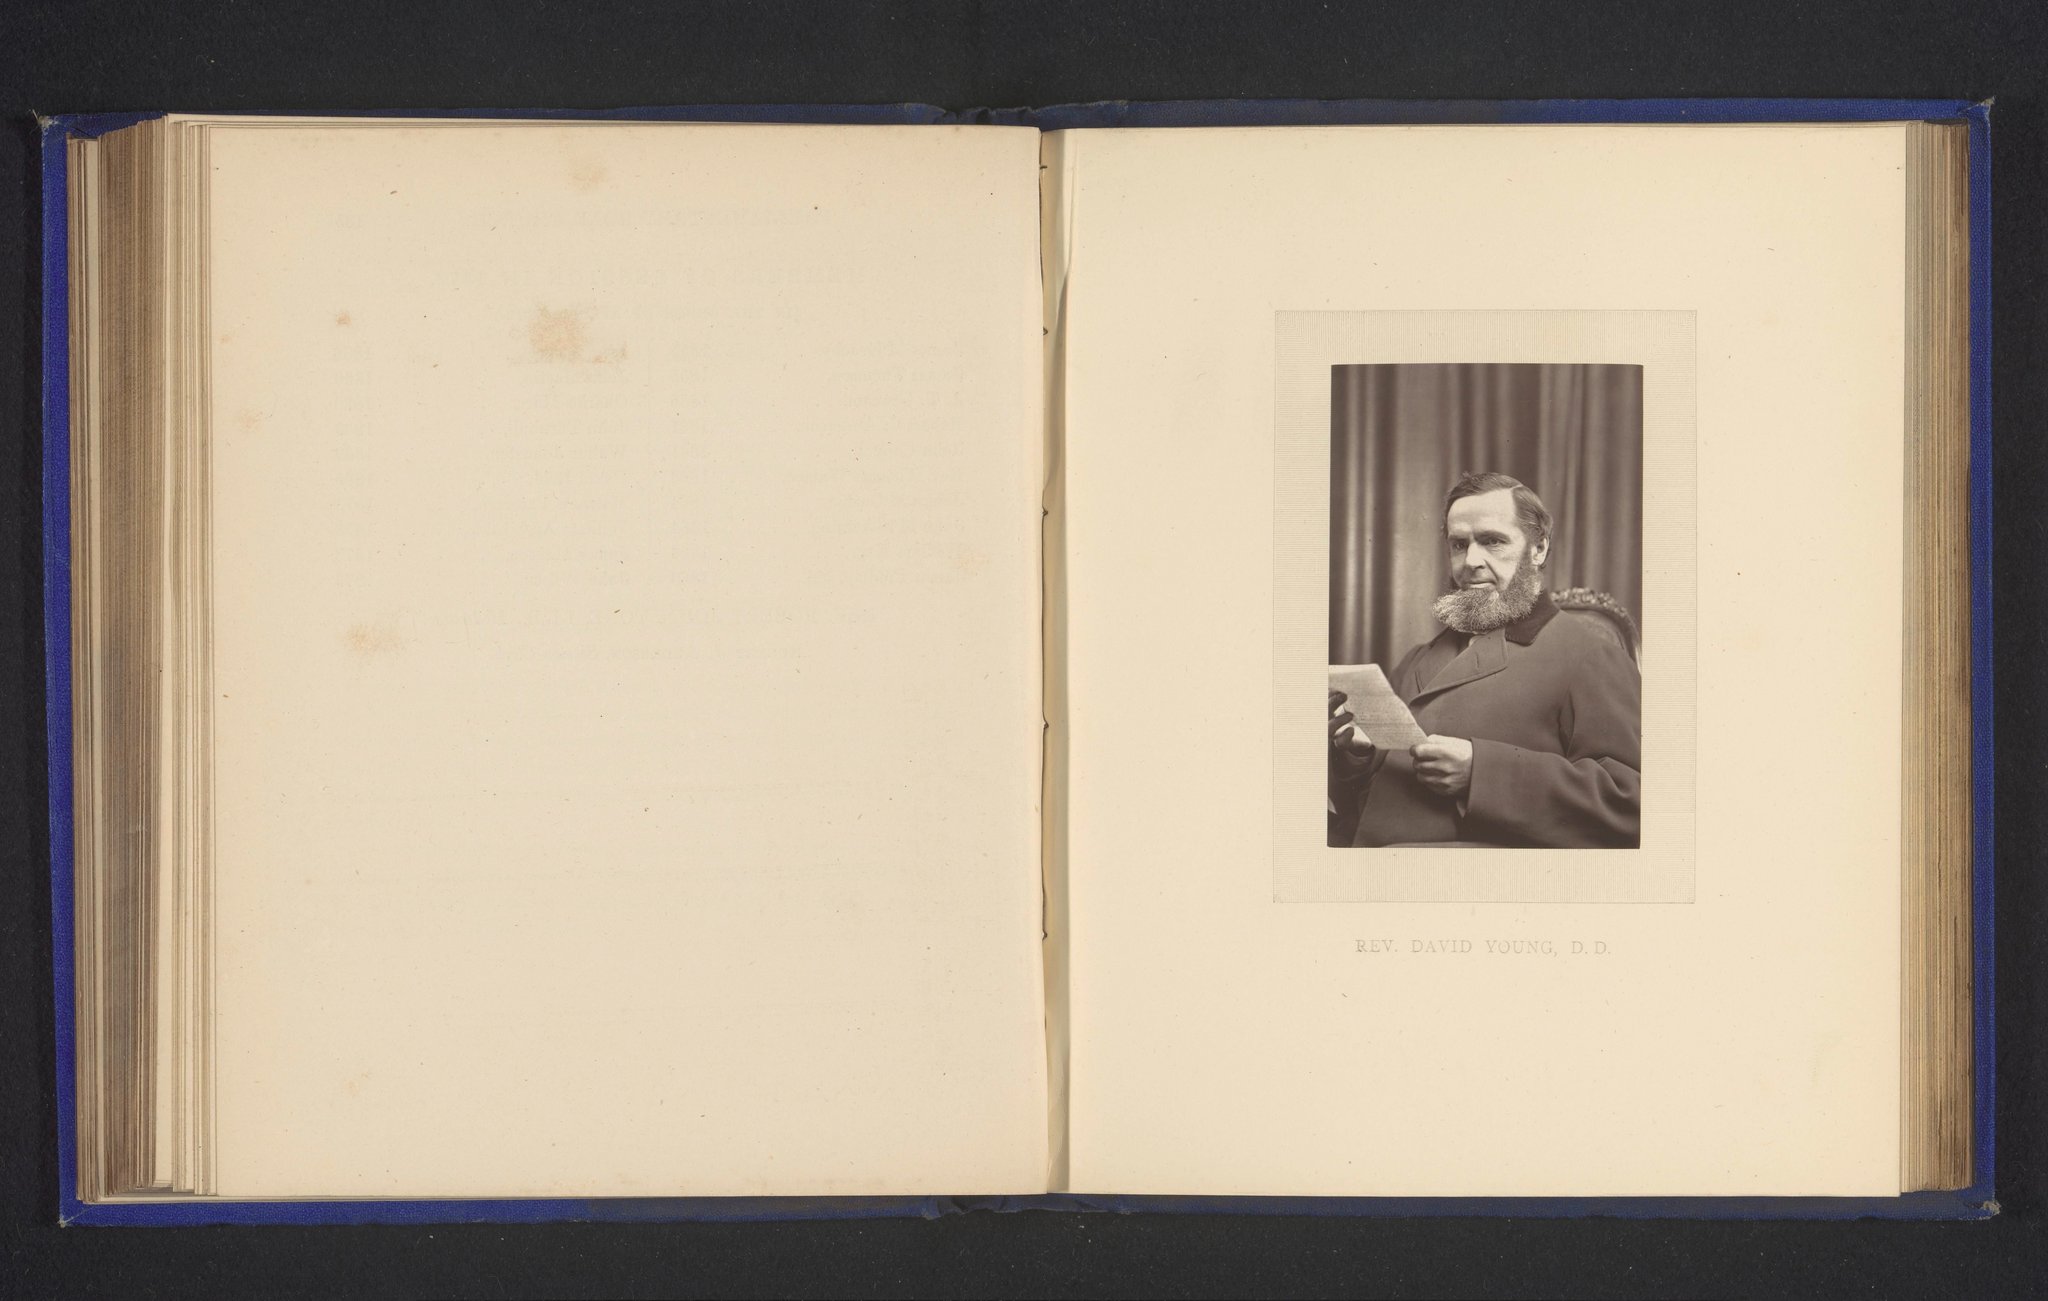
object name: photomechanical print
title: Portret van David Young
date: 1865-1875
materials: paper, photographic support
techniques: carbon print, woodburytype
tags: functionaries and dignitaries (with name) ~ protestant churches